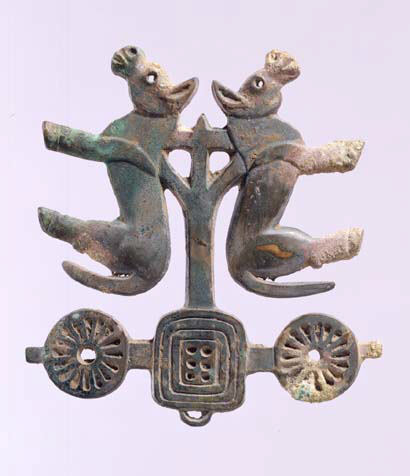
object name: plaque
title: Plaque in the Shape of a Chariot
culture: chinese, northeast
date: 800-601 BCE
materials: bronze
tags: chariots